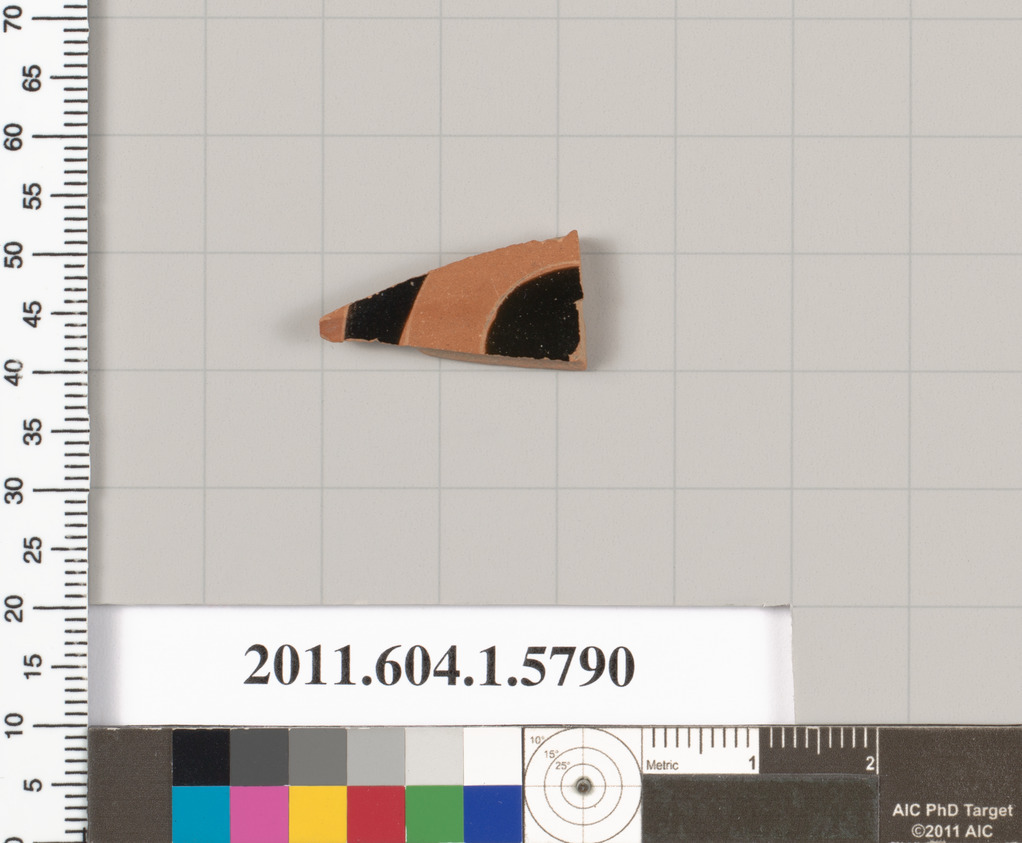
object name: kylix fragment, eye cup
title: Terracotta fragment of a kylix: eye-cup (drinking cup)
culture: greek, attic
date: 525-510 BCE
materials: terracotta